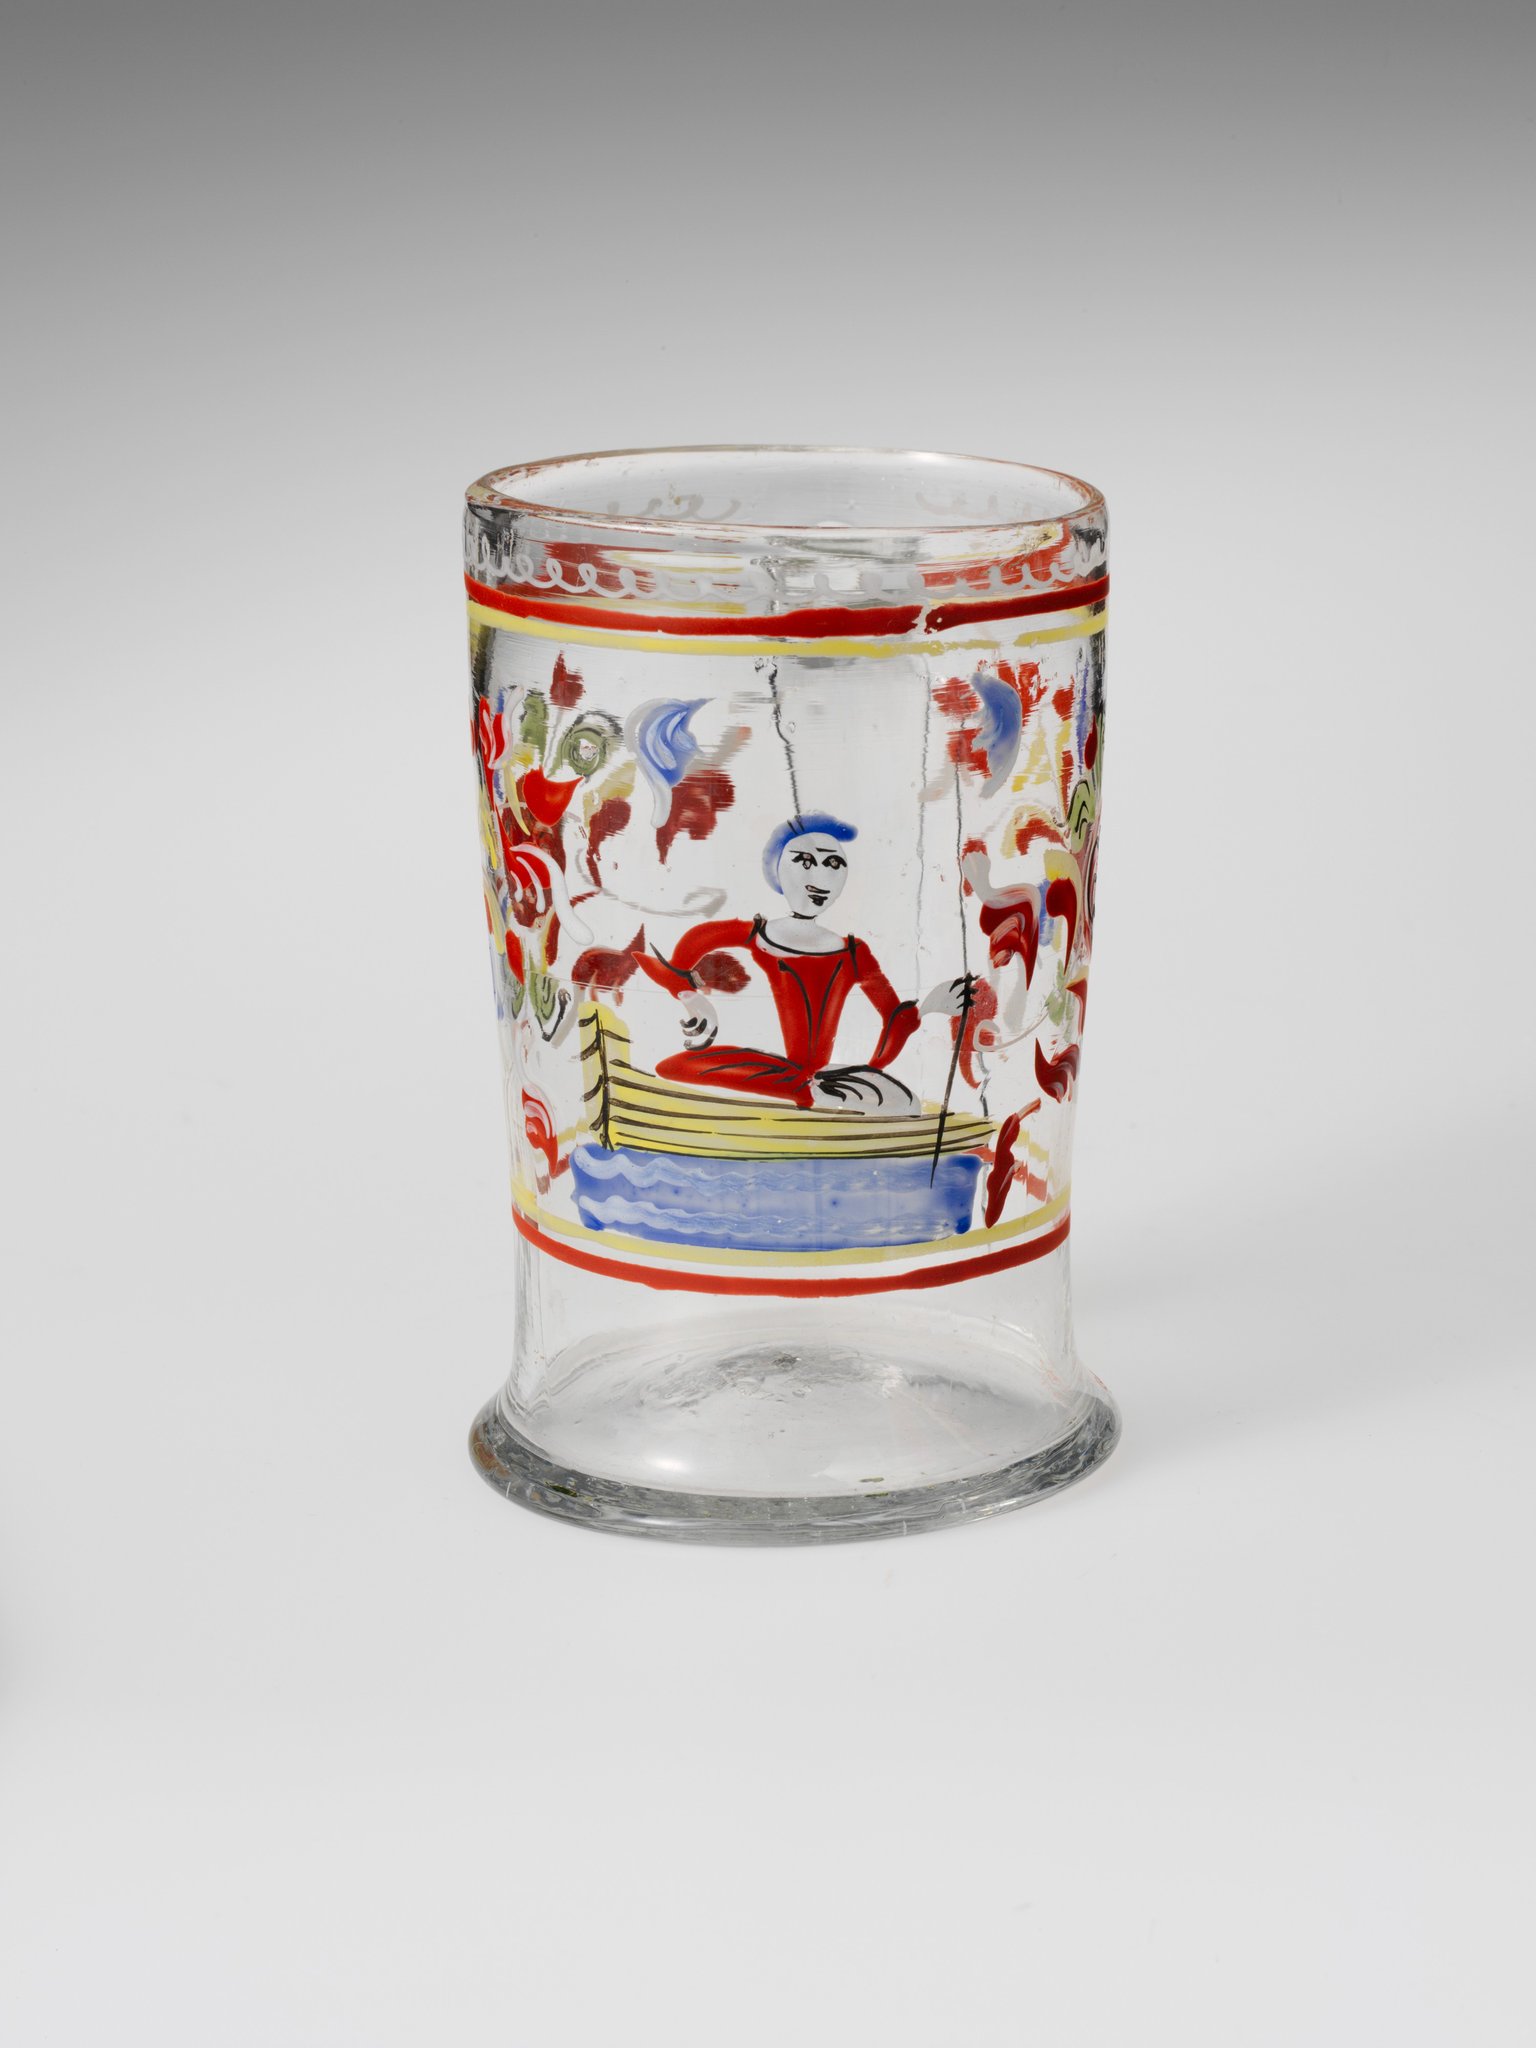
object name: mug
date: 1701-1800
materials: enamel, glass, lead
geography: czech republic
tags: women